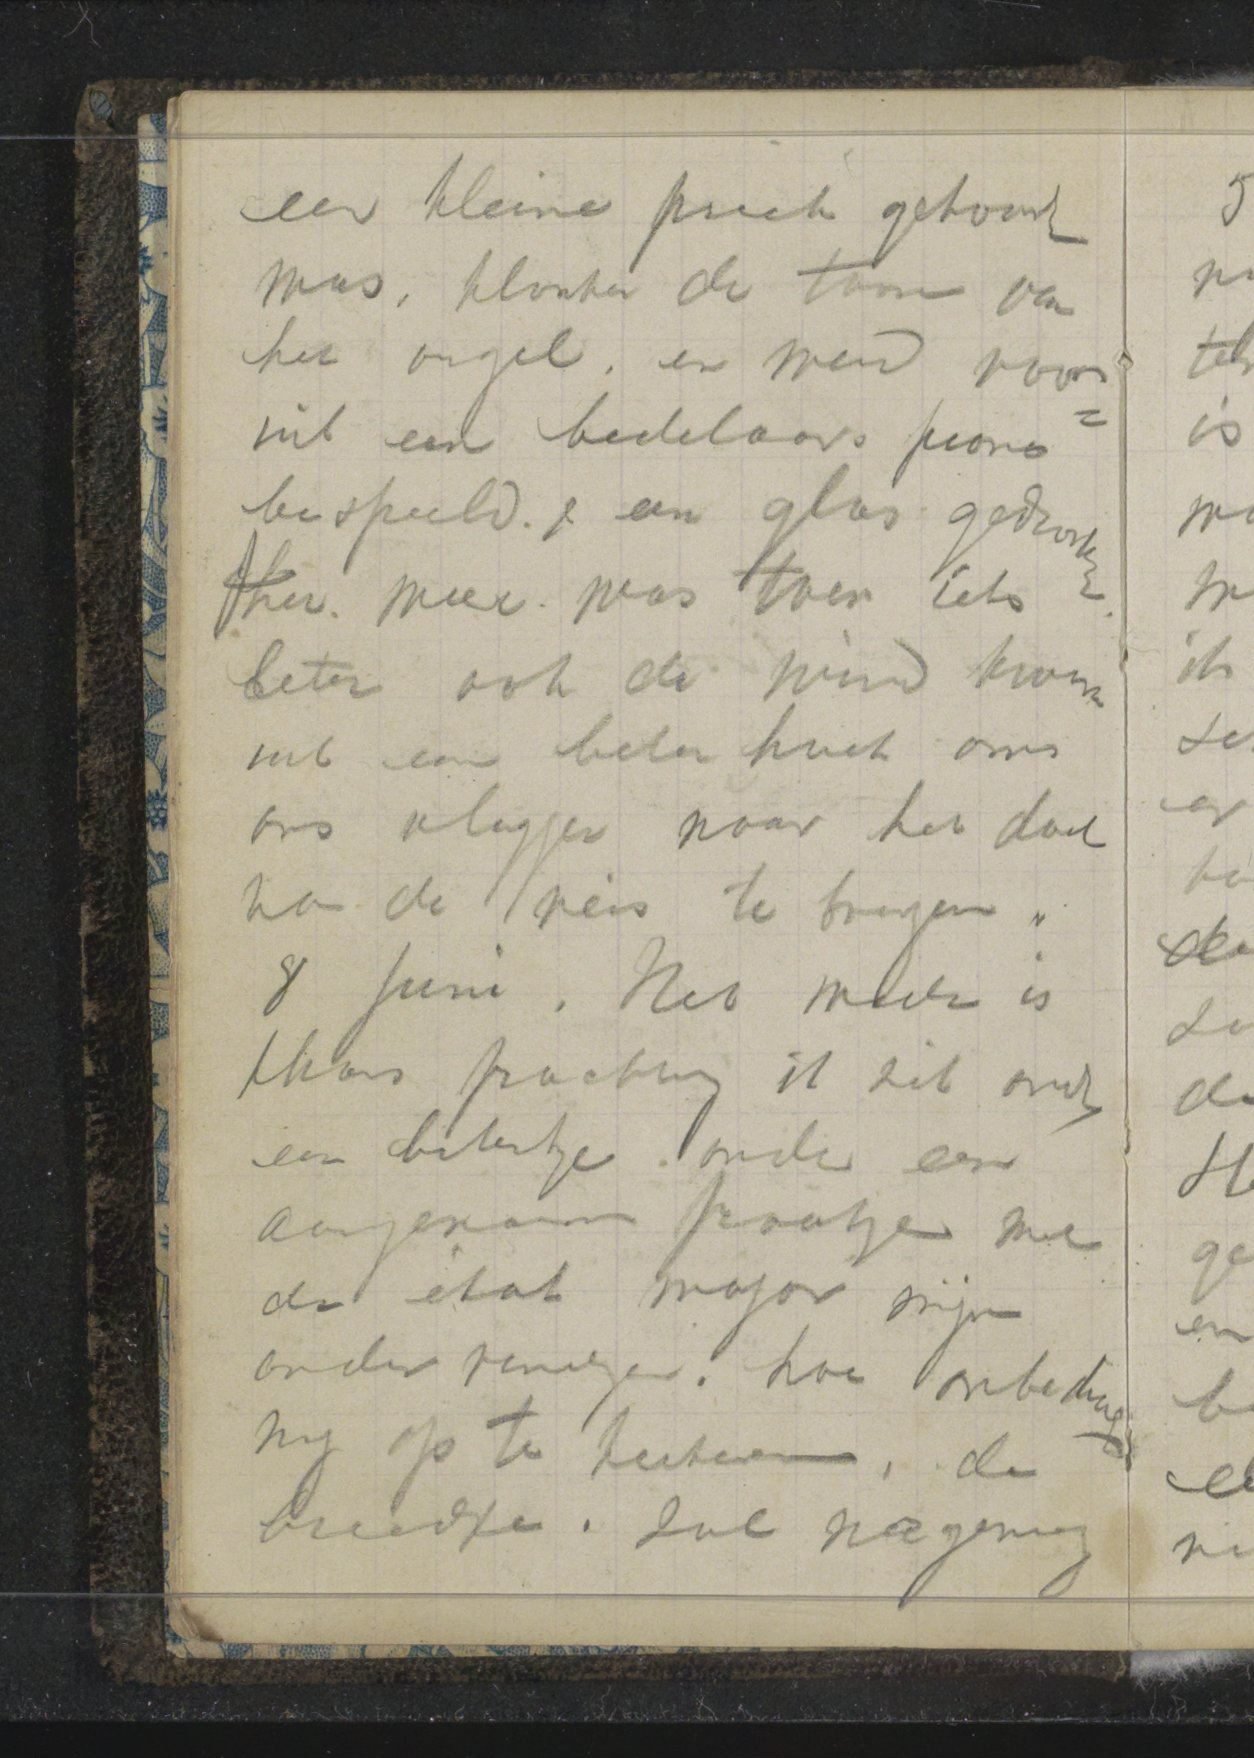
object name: sketchbook leaf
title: Reisverslag van begin juni 1880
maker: louis apol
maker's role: draughtsman, painter, print maker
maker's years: 1850-1936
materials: pencil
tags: nova zembla expedities 1880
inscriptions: annotation: ‘een kleine preek getoond / was, klonken de tonen van / het orgel, en werd voor / uit een bedelaars piano / bespeeld. & en een glas gedronken. [...]’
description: Blad 3 verso uit een schetsboek met 110 bladen betekend tijdens de expeditie naar Nova Zembla in 1880.